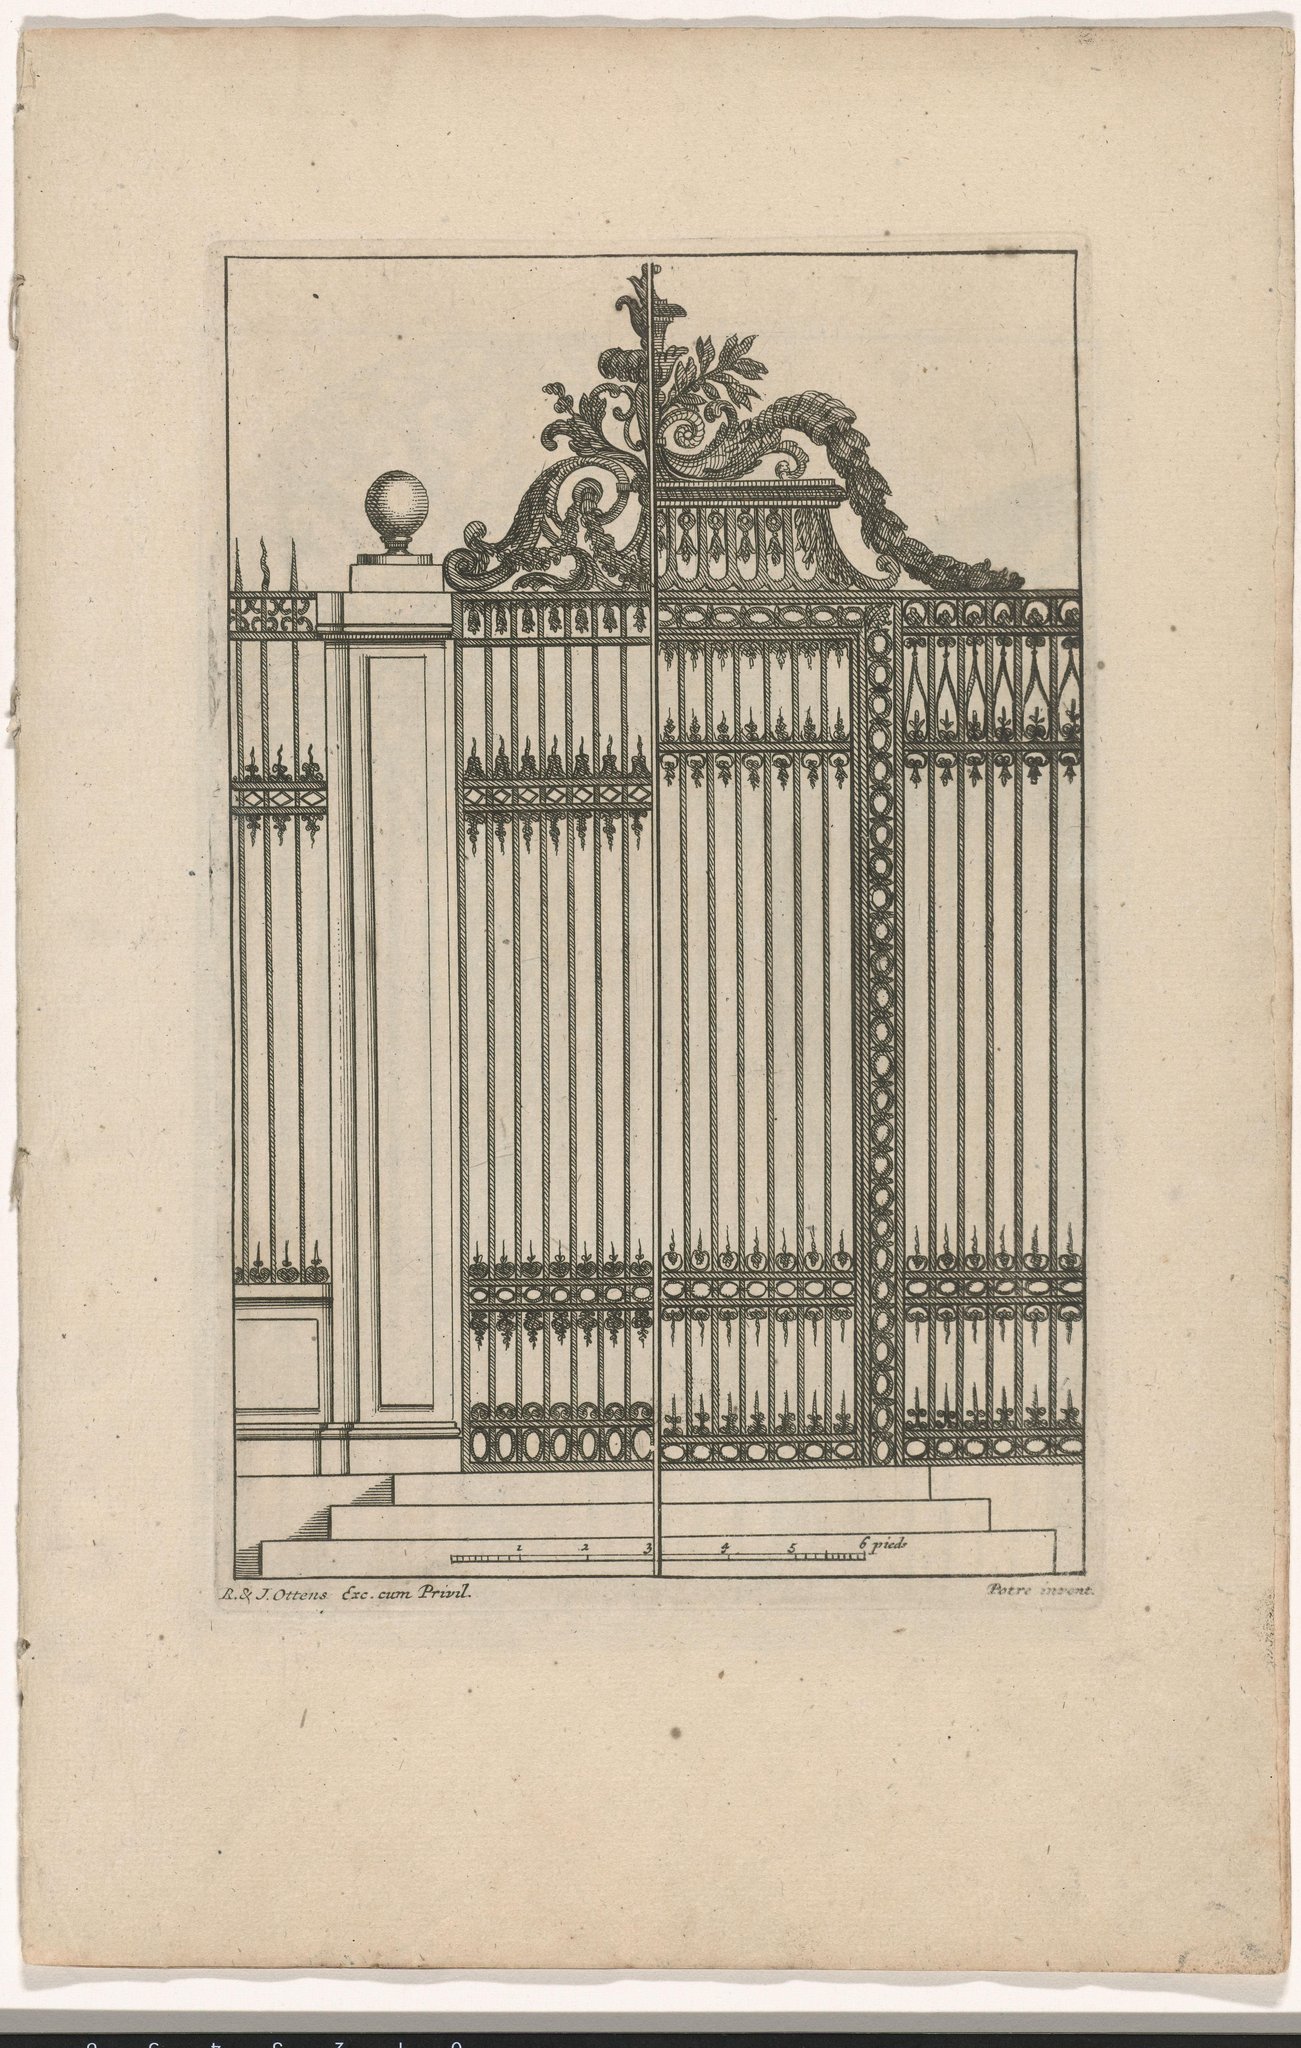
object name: titelblad, titelpagina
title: Smeedwerk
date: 1726-1750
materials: paper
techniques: etching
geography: netherlands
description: Hek met variant voor de rechterhelft. Tegenzijdige kopie naar titelblad uit de serie Liure de Serurerie. Uit serie van 6 bladen met Nederlandse tegenzijdige kopieën naar bladen uit de serie Liure de Serurerie, ontworpen door Jean Lepautre, en bladen uit een andere serie. Tweede druk.